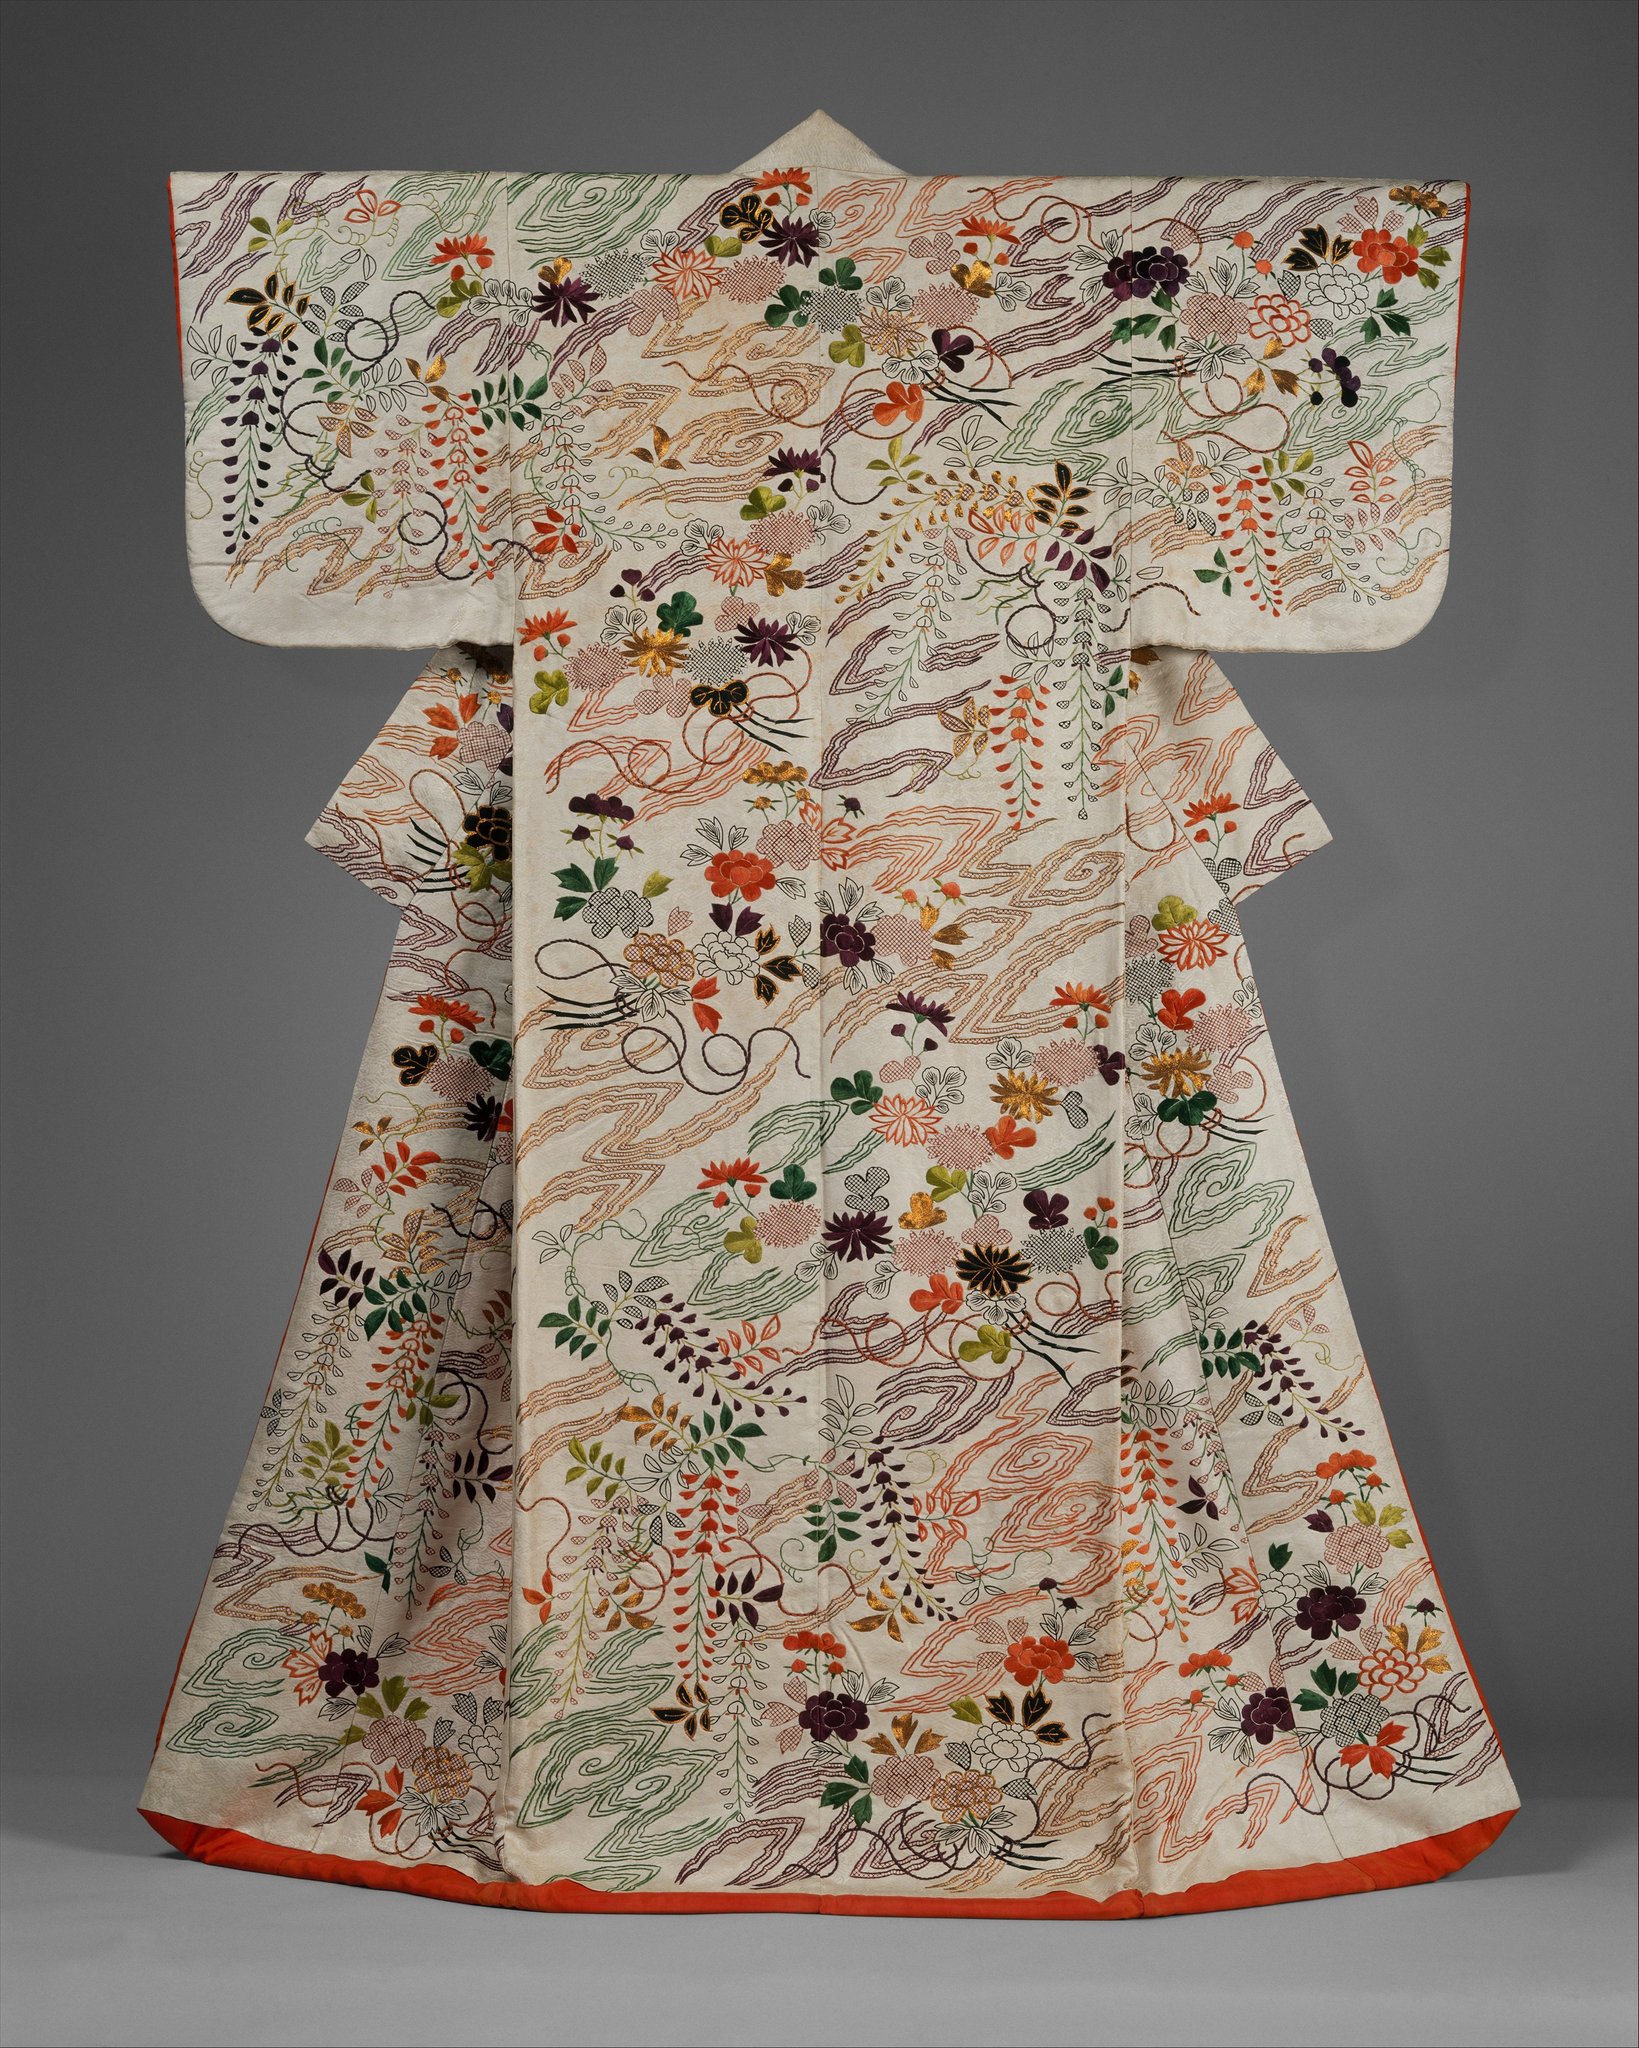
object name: formal robe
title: Outer Robe (Uchikake) with Chrysanthemum and Wisteria Bouquets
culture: japanese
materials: metal thread, silk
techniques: damask, dyeing, embroidery, painting, resist